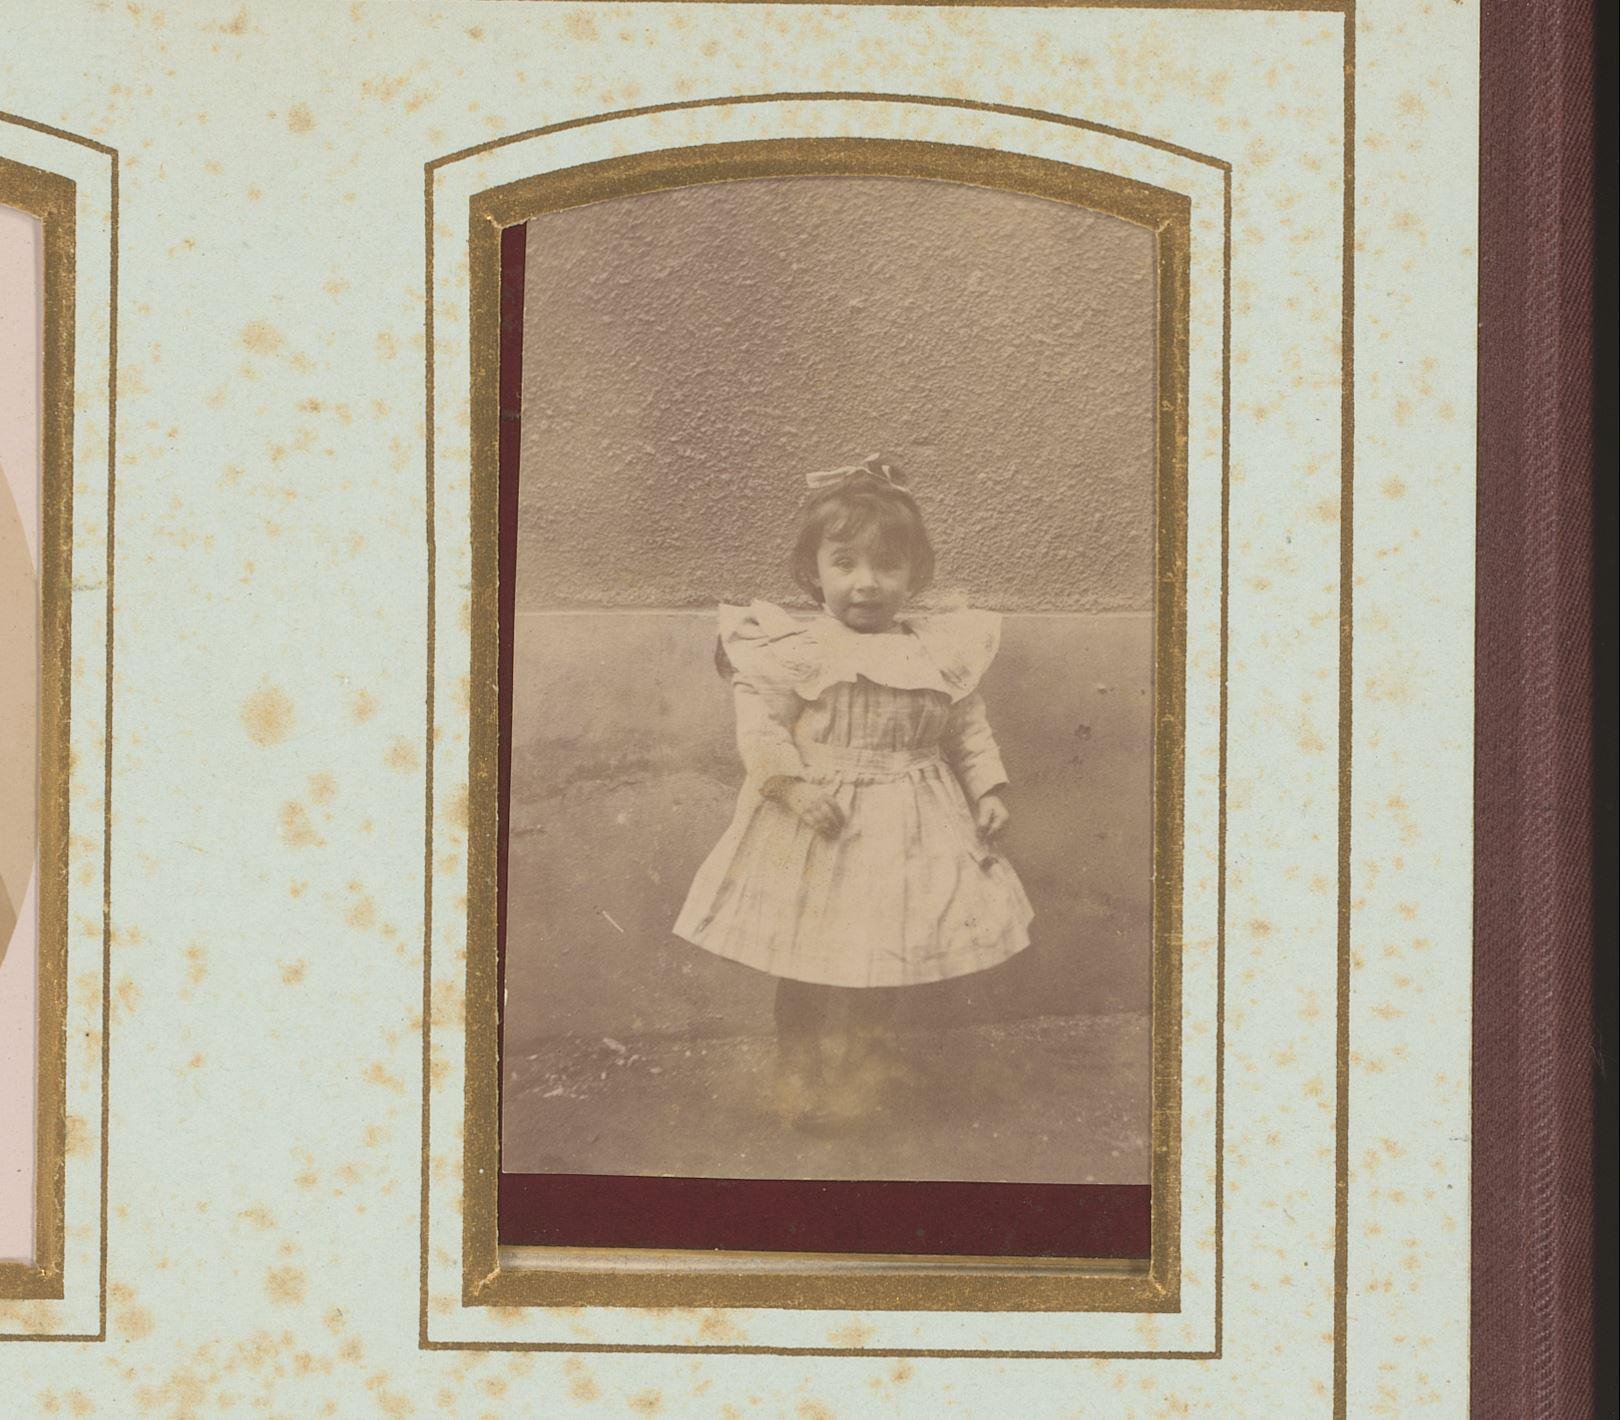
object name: album leaf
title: Portret van een meisje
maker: Anonymous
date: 1890-1920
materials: cardboard, photographic support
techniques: gelatin silver print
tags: girl (child between toddler and youth)